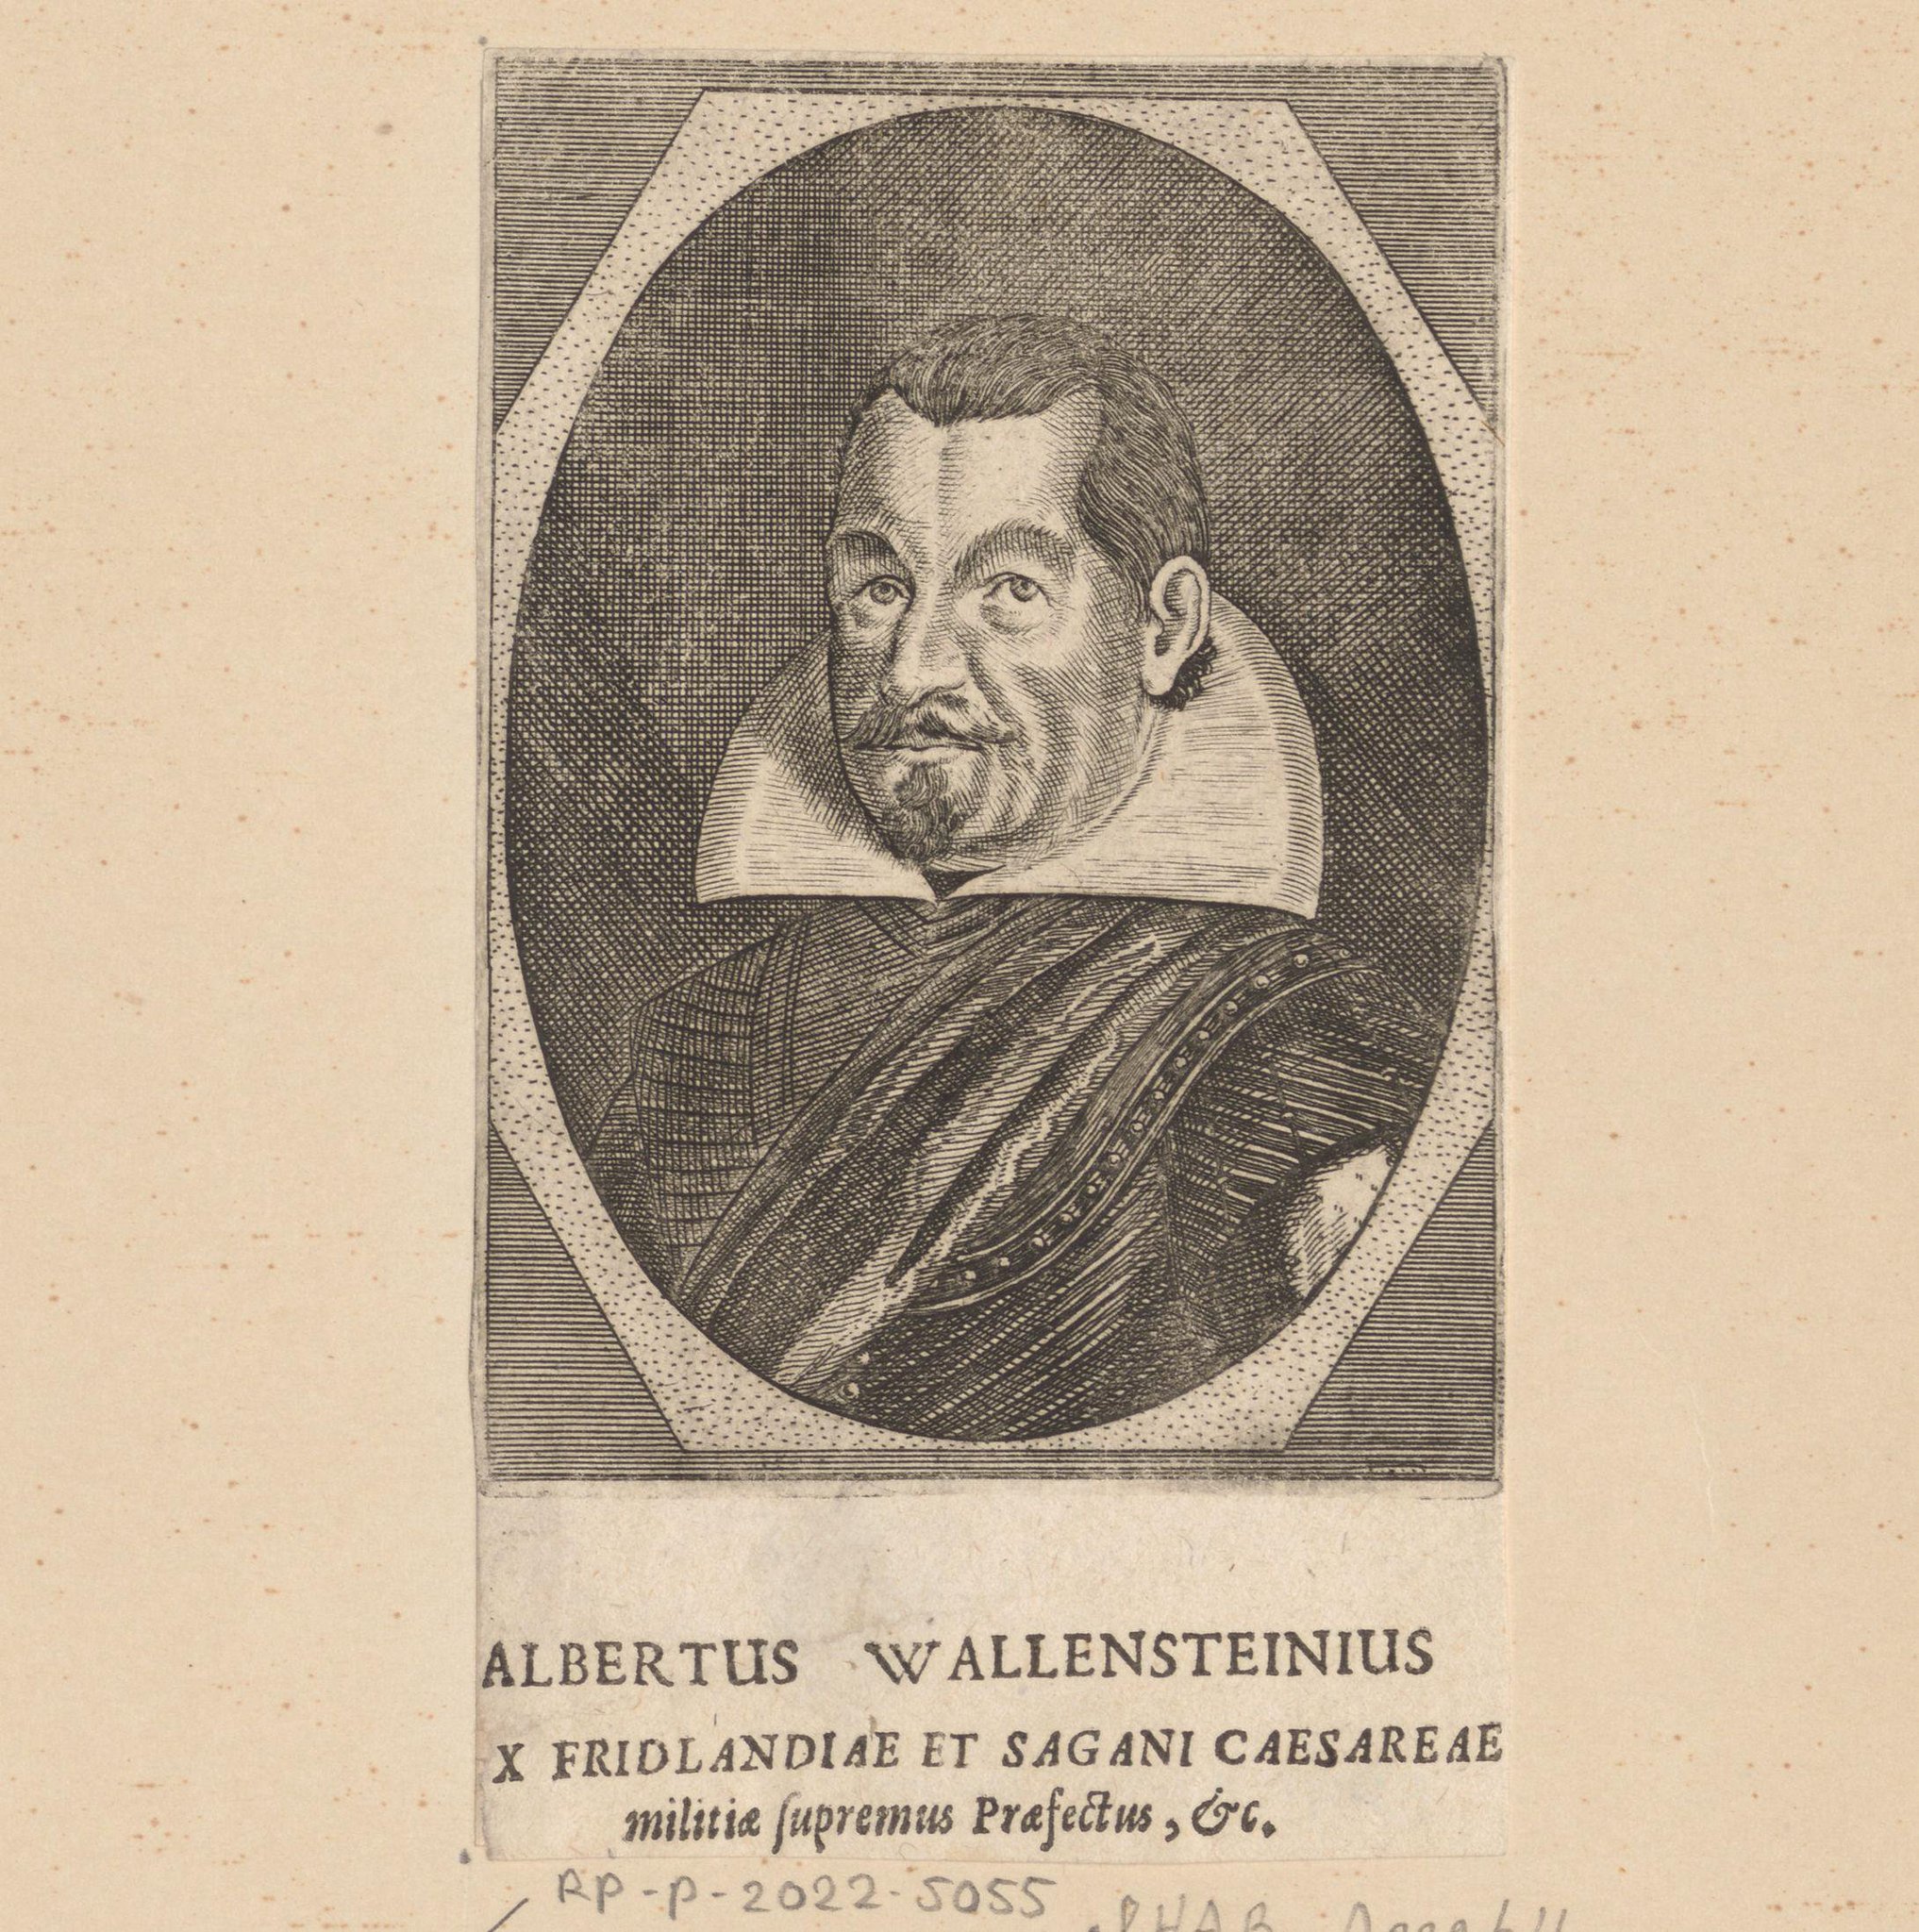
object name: print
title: Portret van Albrecht von Wallenstein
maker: Anonymous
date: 1652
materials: paper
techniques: engraving, letterpress printing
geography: northern netherlands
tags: commander-in-chief, general, marshal, historical persons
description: Prent mogelijk gebruikt in: Brachelius, Johannes Adolphus. Historiarum nostri temporis Editio Secunda. Keulen: Johann Anton Kinck, dl. 1, 1652.